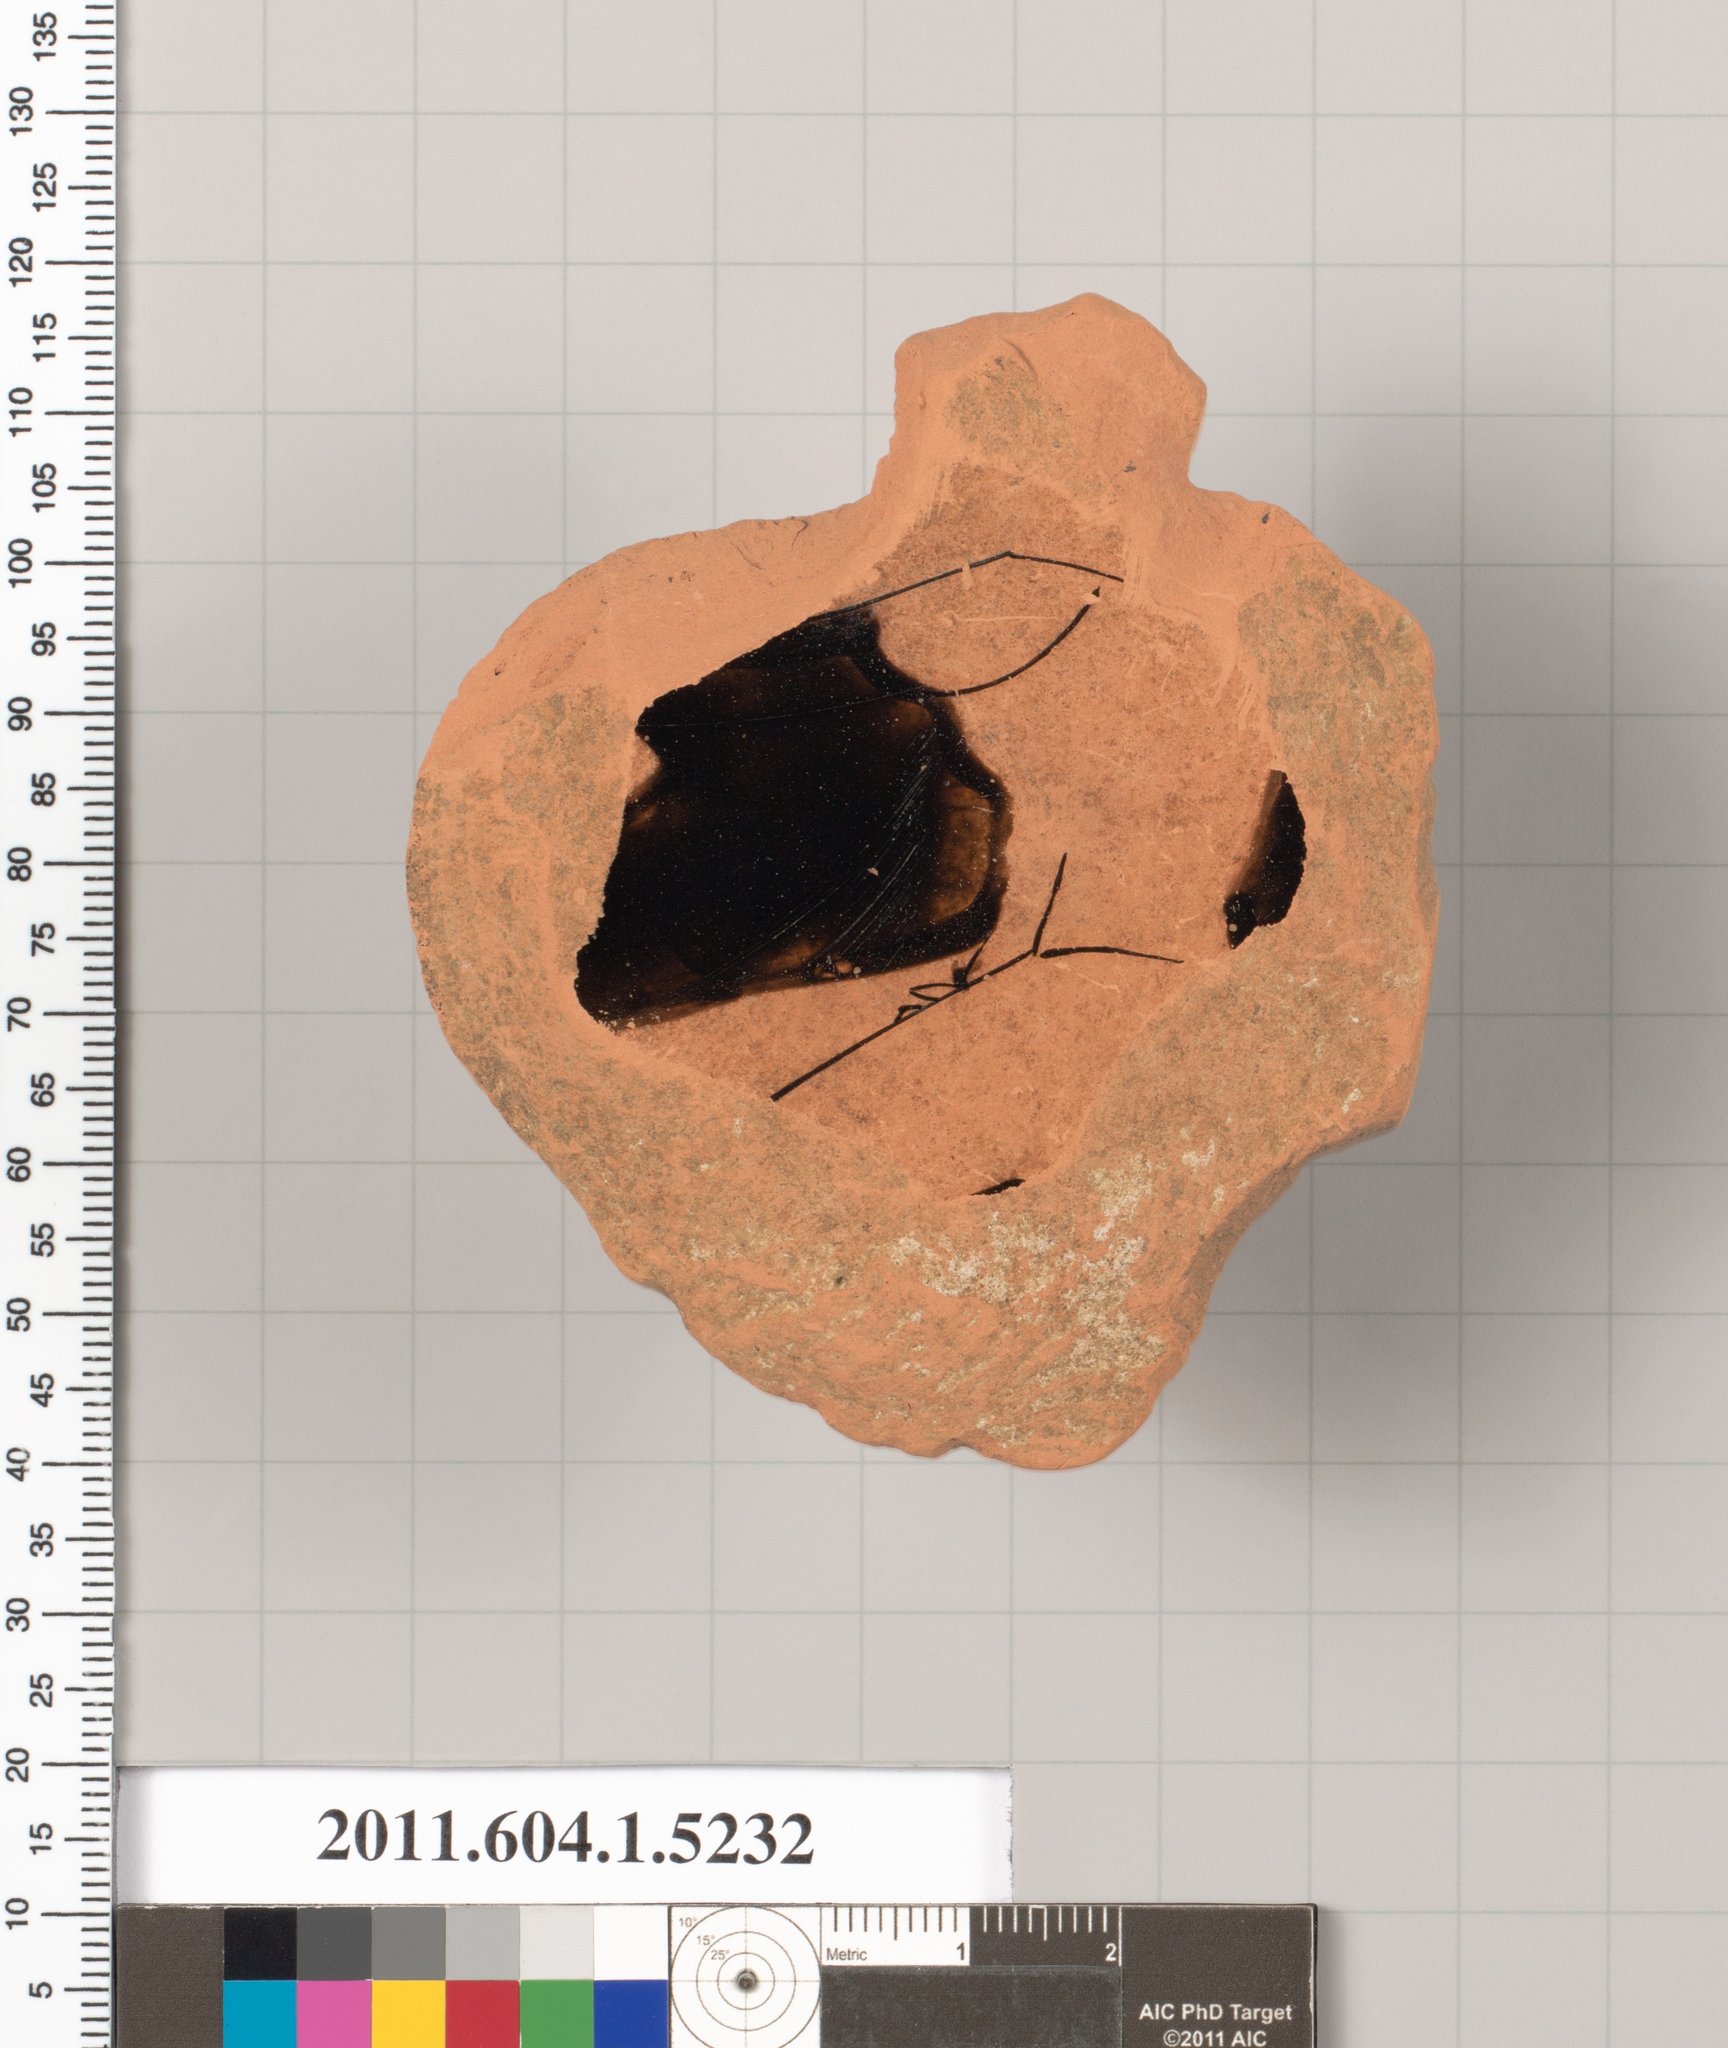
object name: kylix fragment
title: Terracotta fragment of a kylix (drinking cup)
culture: greek, attic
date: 500-480 BCE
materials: terracotta